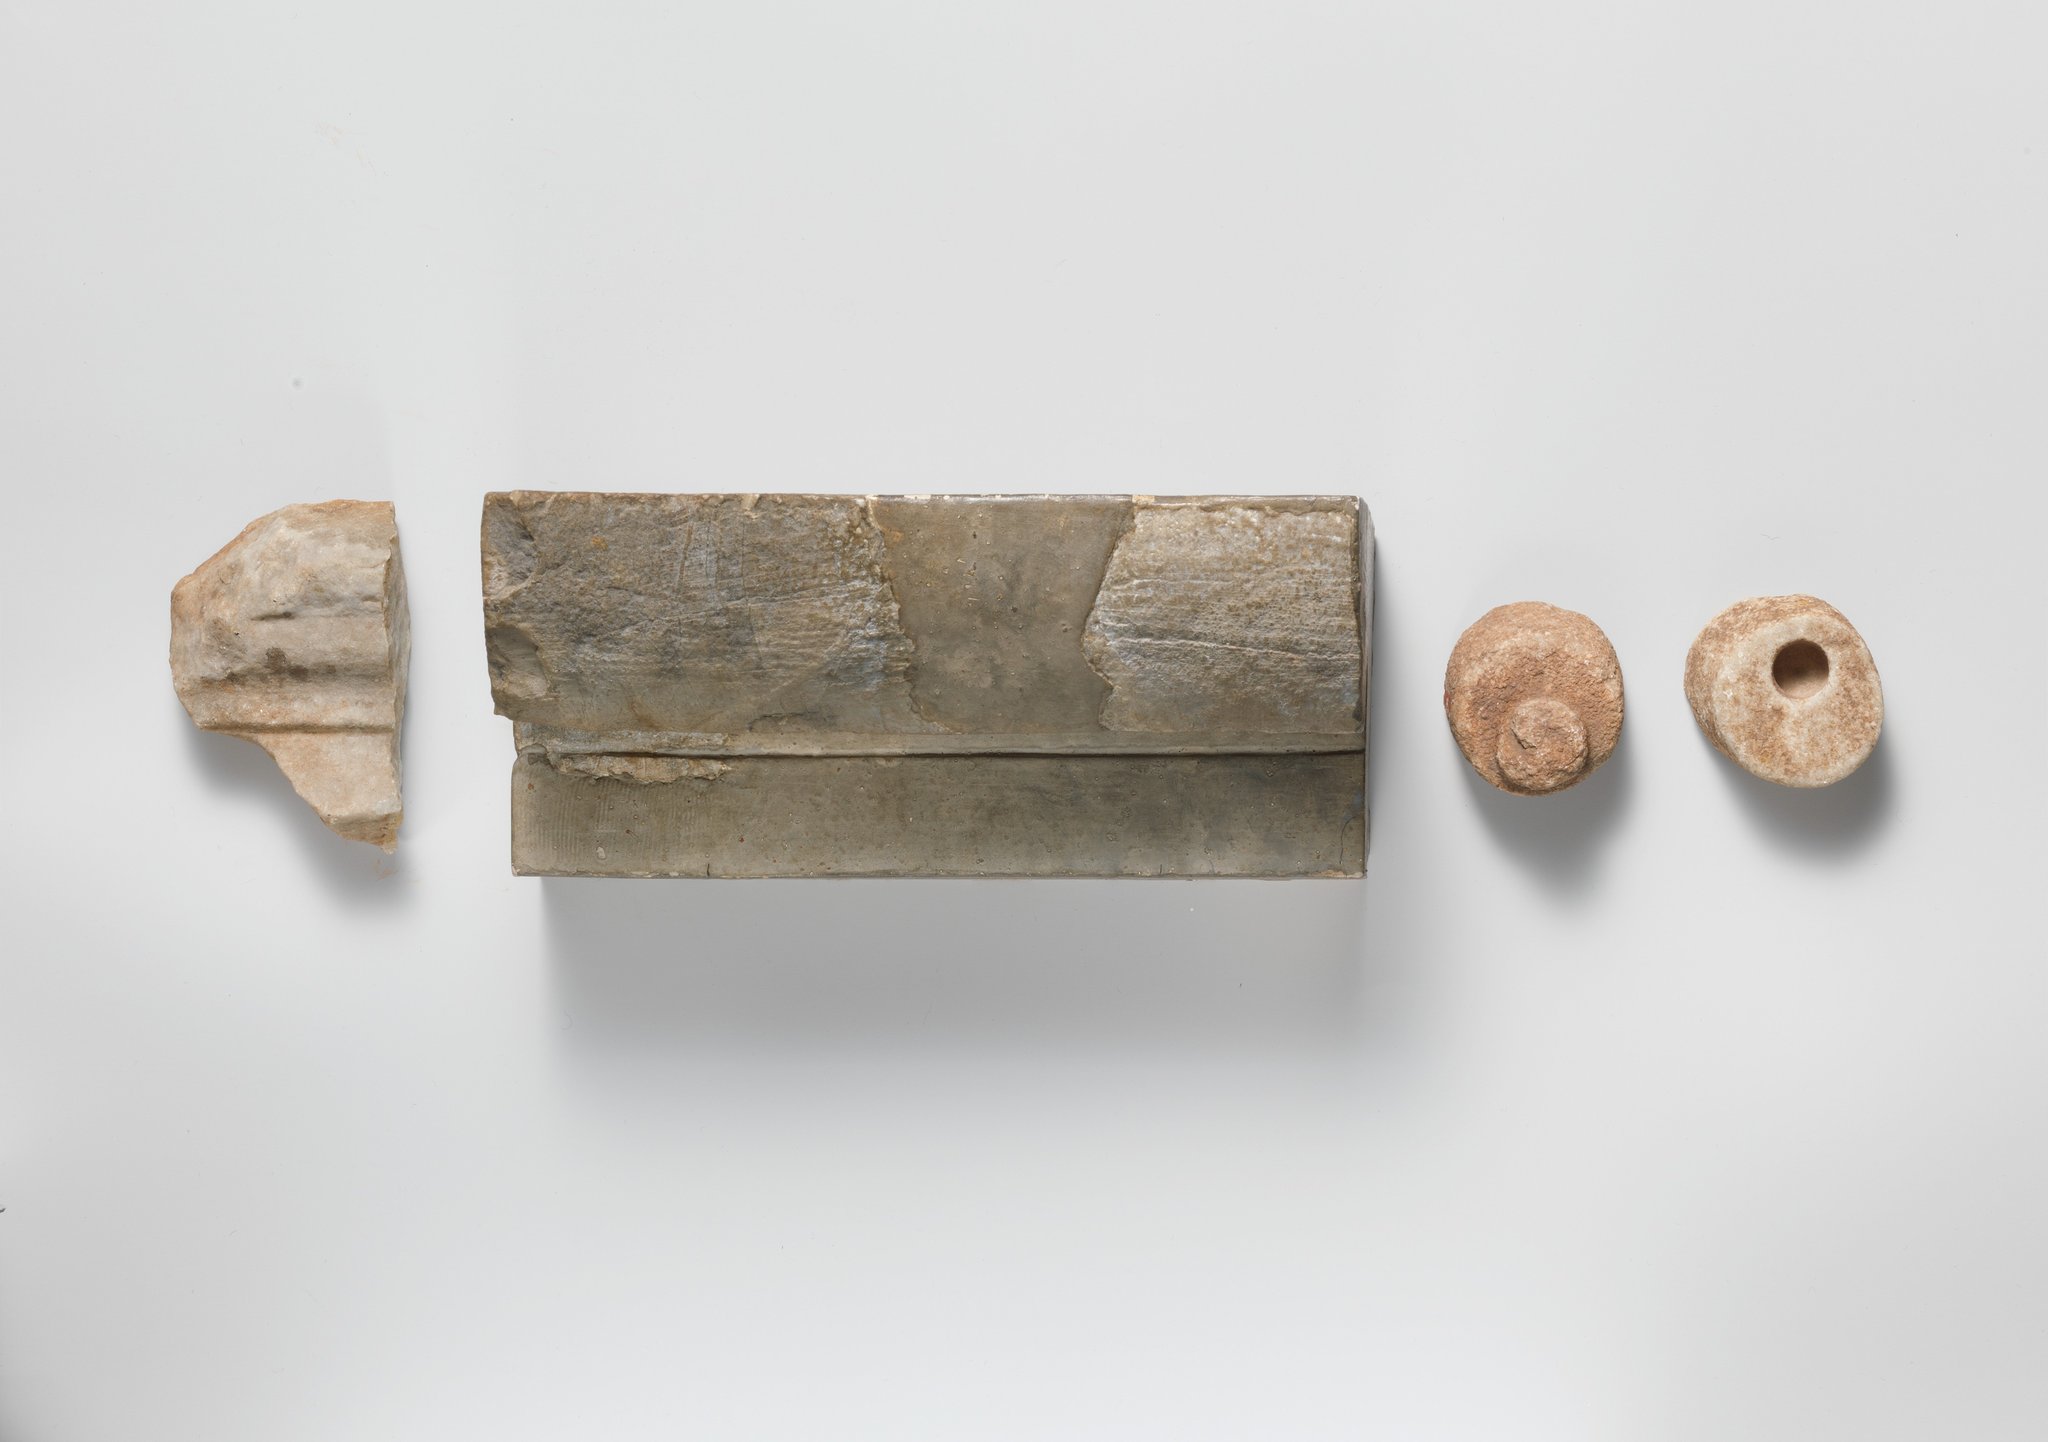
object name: architectural fragment crowning molding of doric cornice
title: Crowning molding of a Doric cornice from a group of fragments from the Temple of Apollo near Phigaleia (Bassae)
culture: greek, arcadian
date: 500-401 BCE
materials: marble